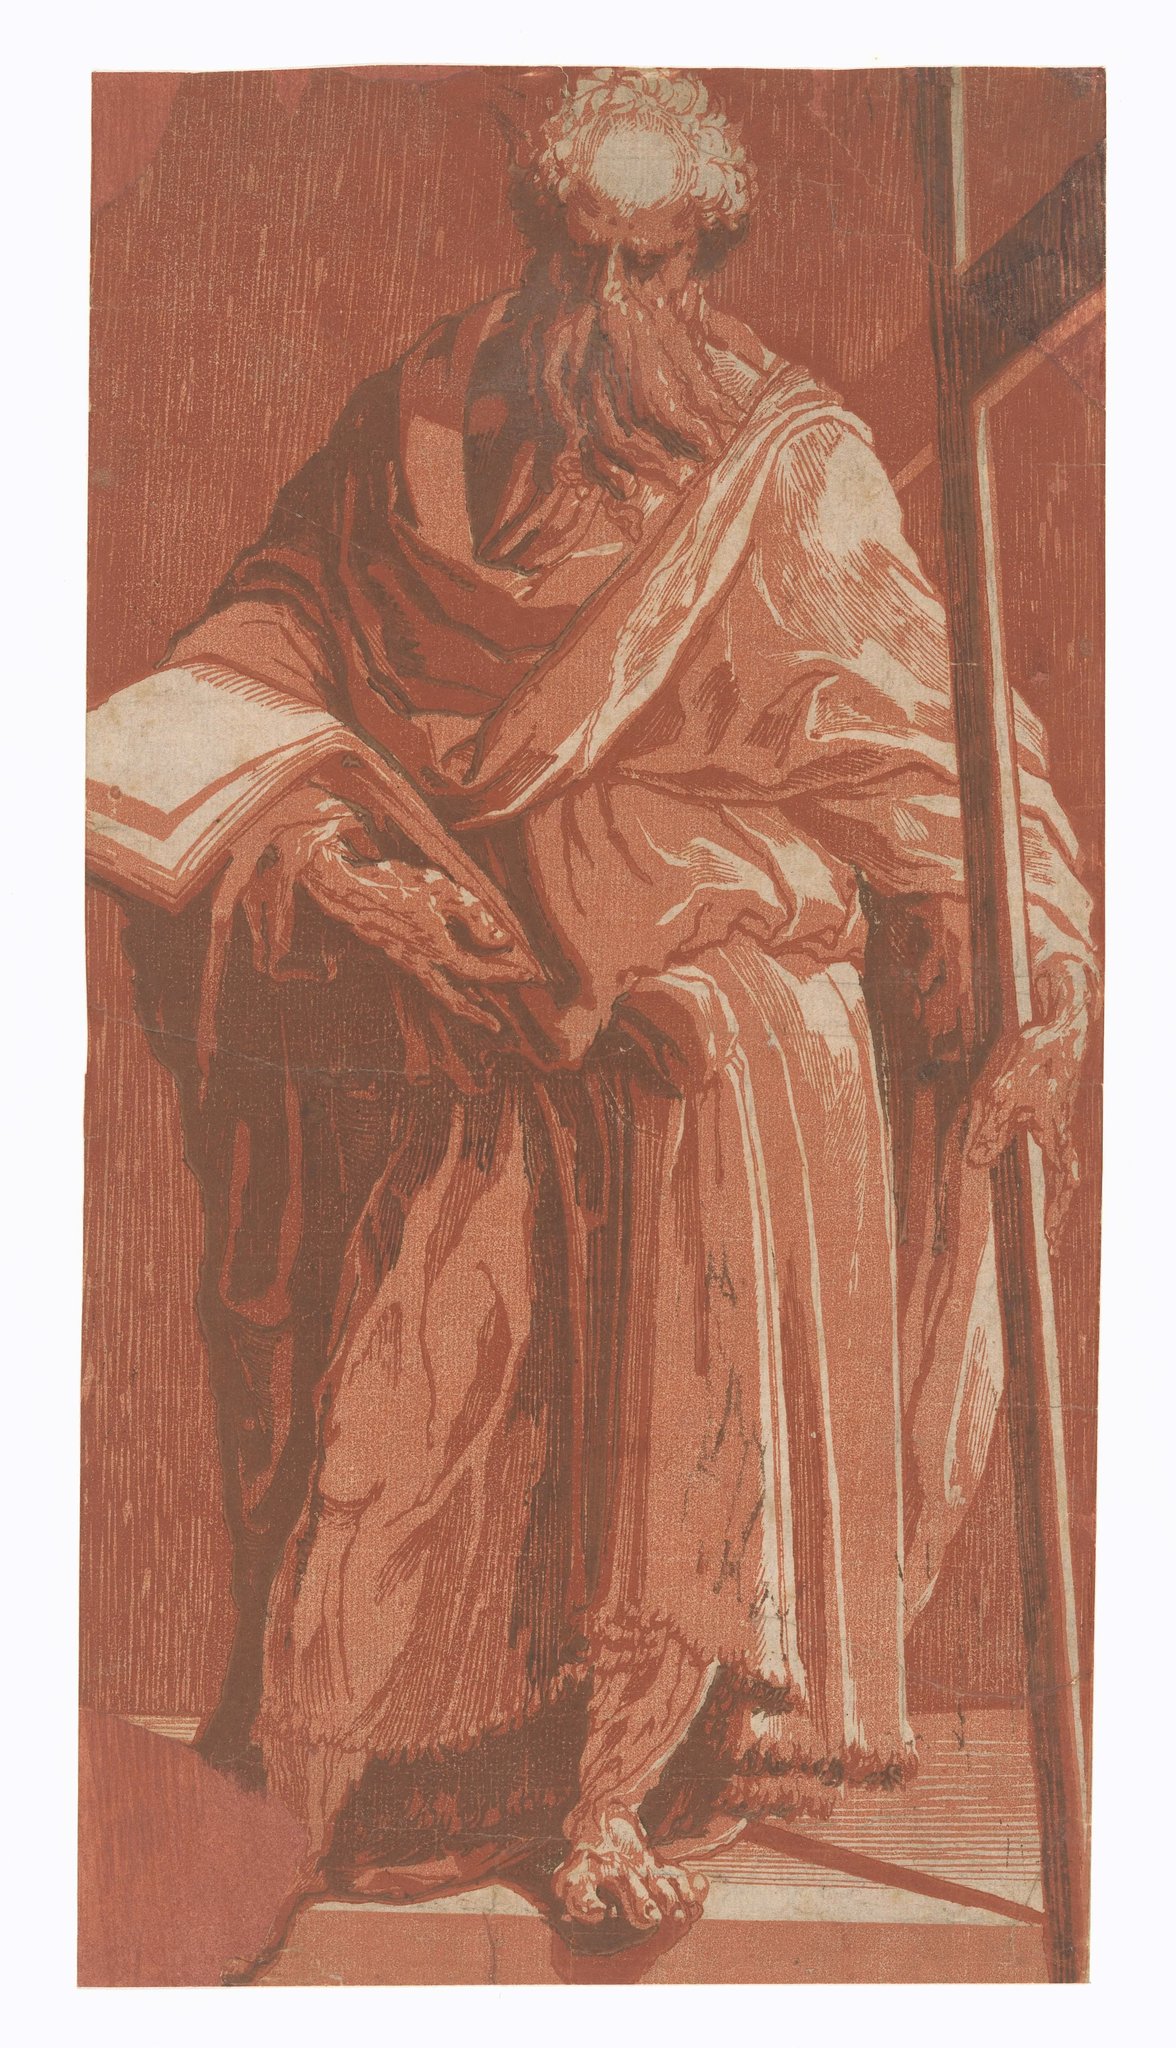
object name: print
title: Heilige Filippus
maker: domenico beccafumi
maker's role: draughtsman, painter, print maker, sculptor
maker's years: 1486-1551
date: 1545-1549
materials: paper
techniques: woodcut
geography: italy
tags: the apostle philip; possible attributes: book, cross, dish with snake, lance, scroll, stone, sword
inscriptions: collector's mark: Lugt 2228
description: De staande apostel Filippus met opengeslagen boek en kruis.